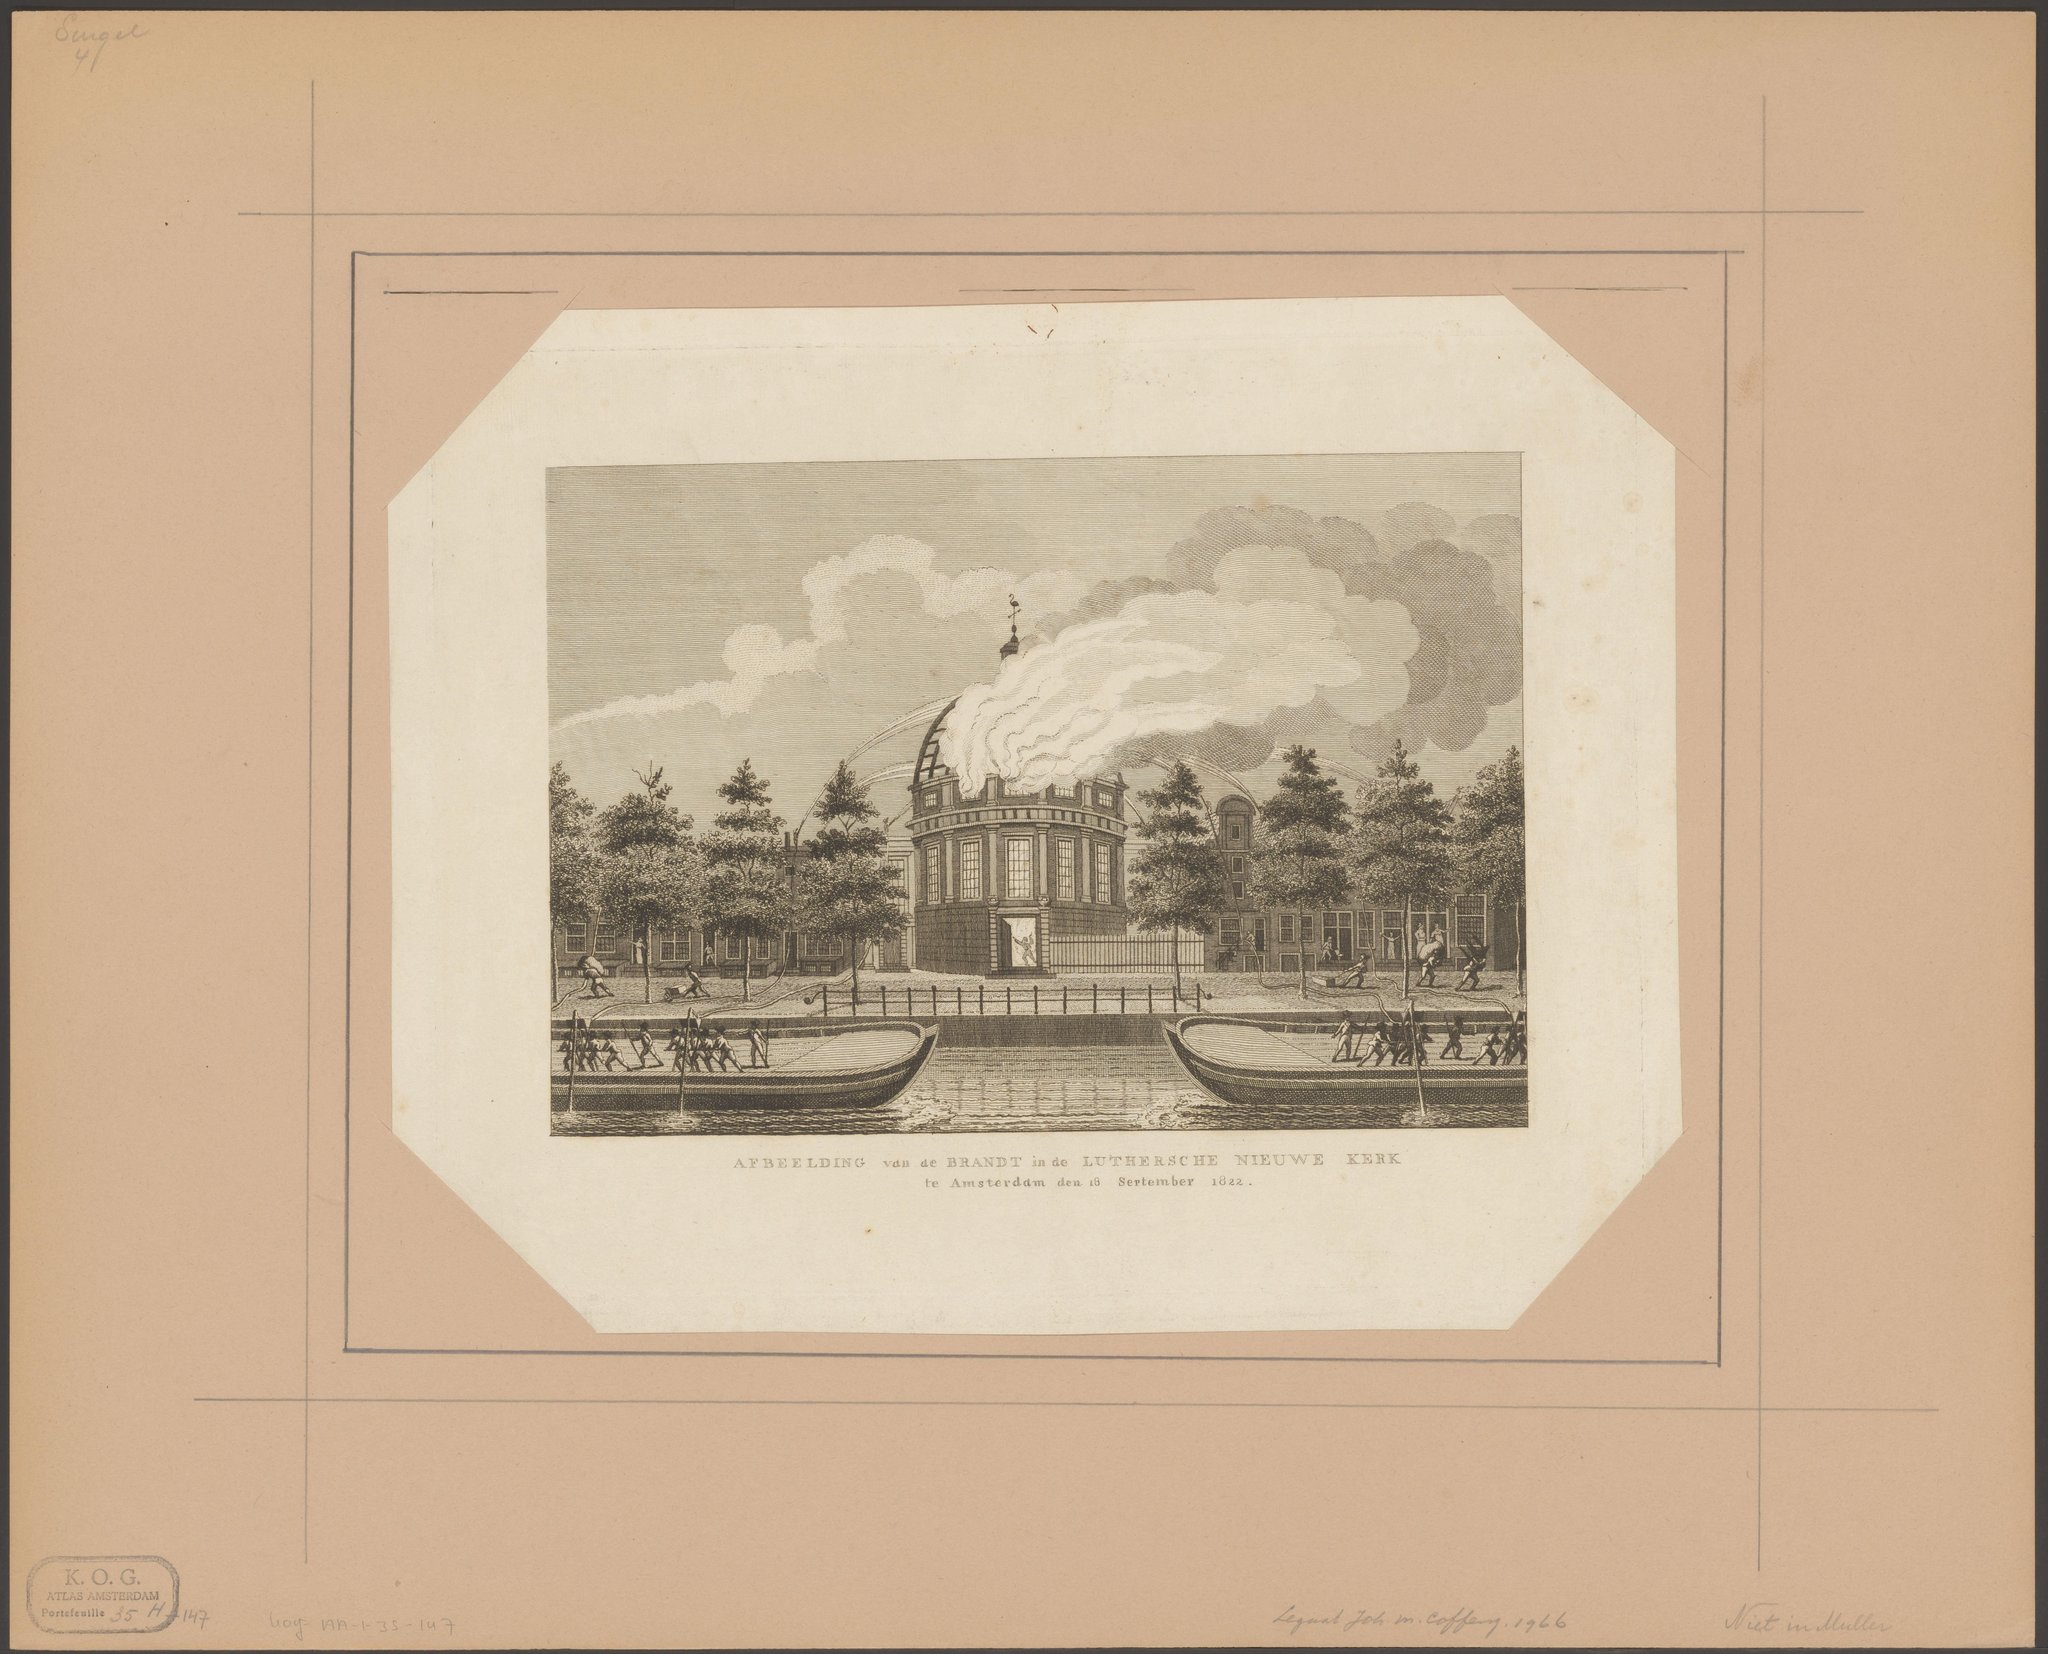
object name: print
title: Brand in de Nieuwe Lutherse Kerk te Amsterdam, 1822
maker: Anonymous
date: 1822-1823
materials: paper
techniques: etching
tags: on fire, ablaze, fire-extinguishing equipment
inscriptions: collector's mark: Lugt 1641b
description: Onderwerpsrubriek binnen de Atlas Amsterdam: Kerkwezen: Ev. Lutherse Gemeente: 1822 Brand in de Nieuwe Luthersche Koepelkerk - Ruïne.